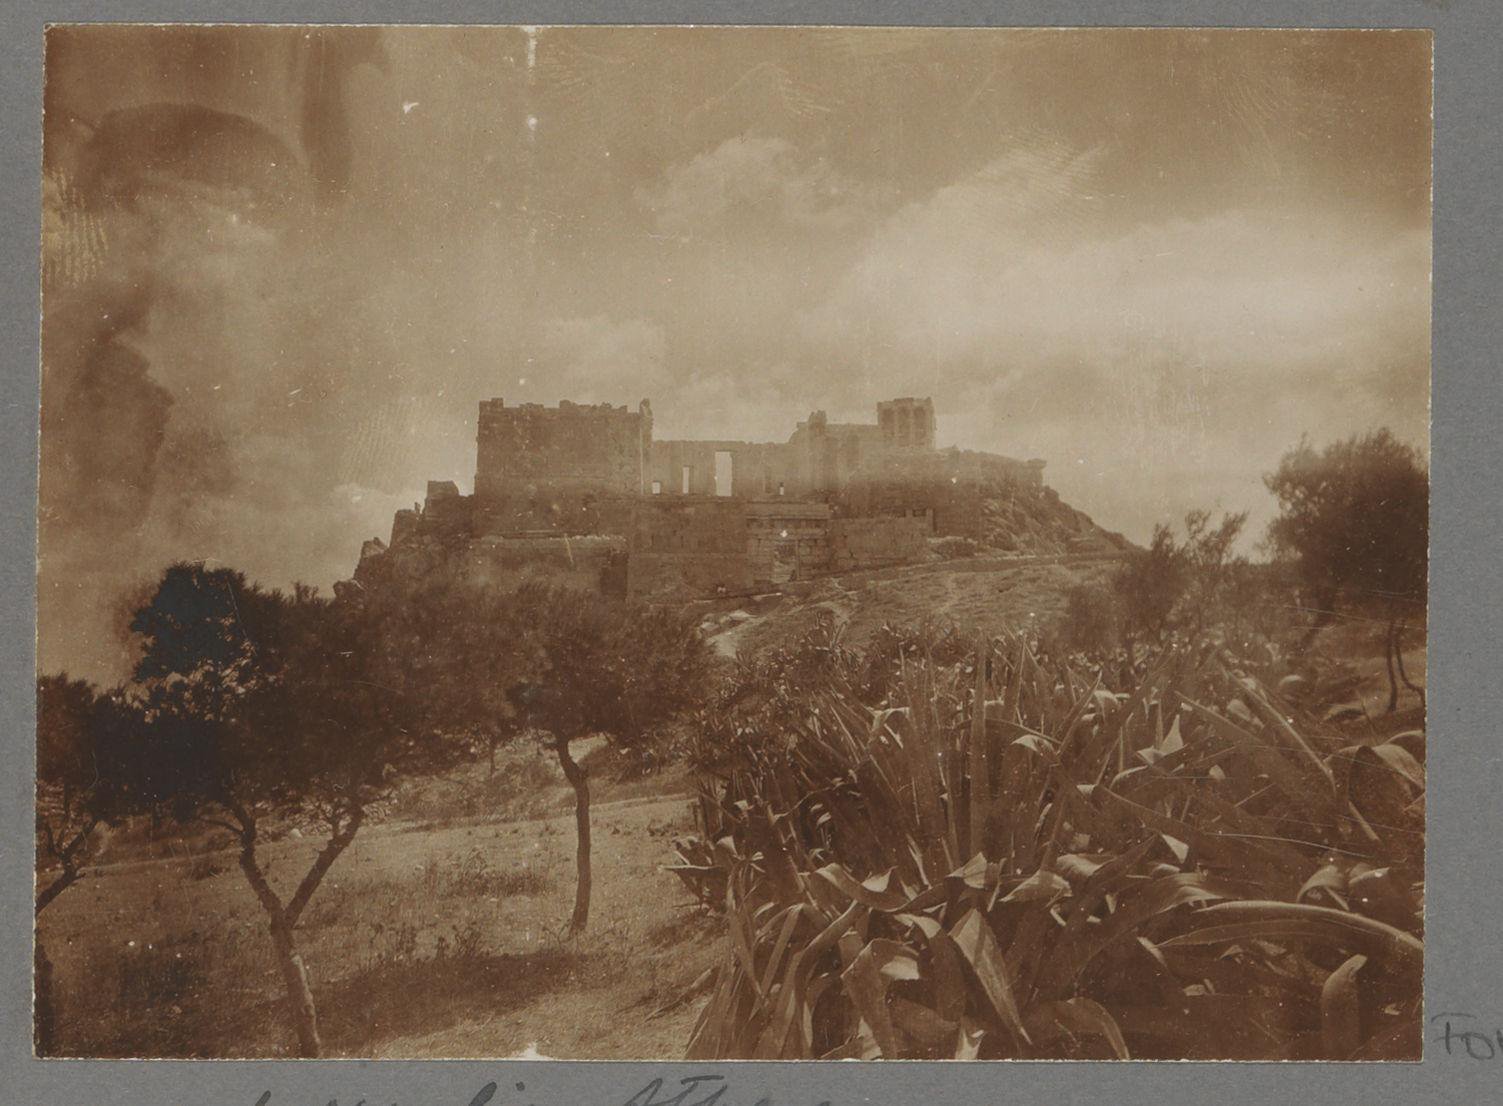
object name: photograph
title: Gezicht op de Akropolis in Athene, op de voorgrond agaven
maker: Anonymous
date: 1905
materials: paper, photographic support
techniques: collodion silver print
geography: athens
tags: prospect of city, town panorama, silhouette of city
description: Onderdeel van Reisalbum met foto's van bezienswaardigheden in Griekenland en Egypte.